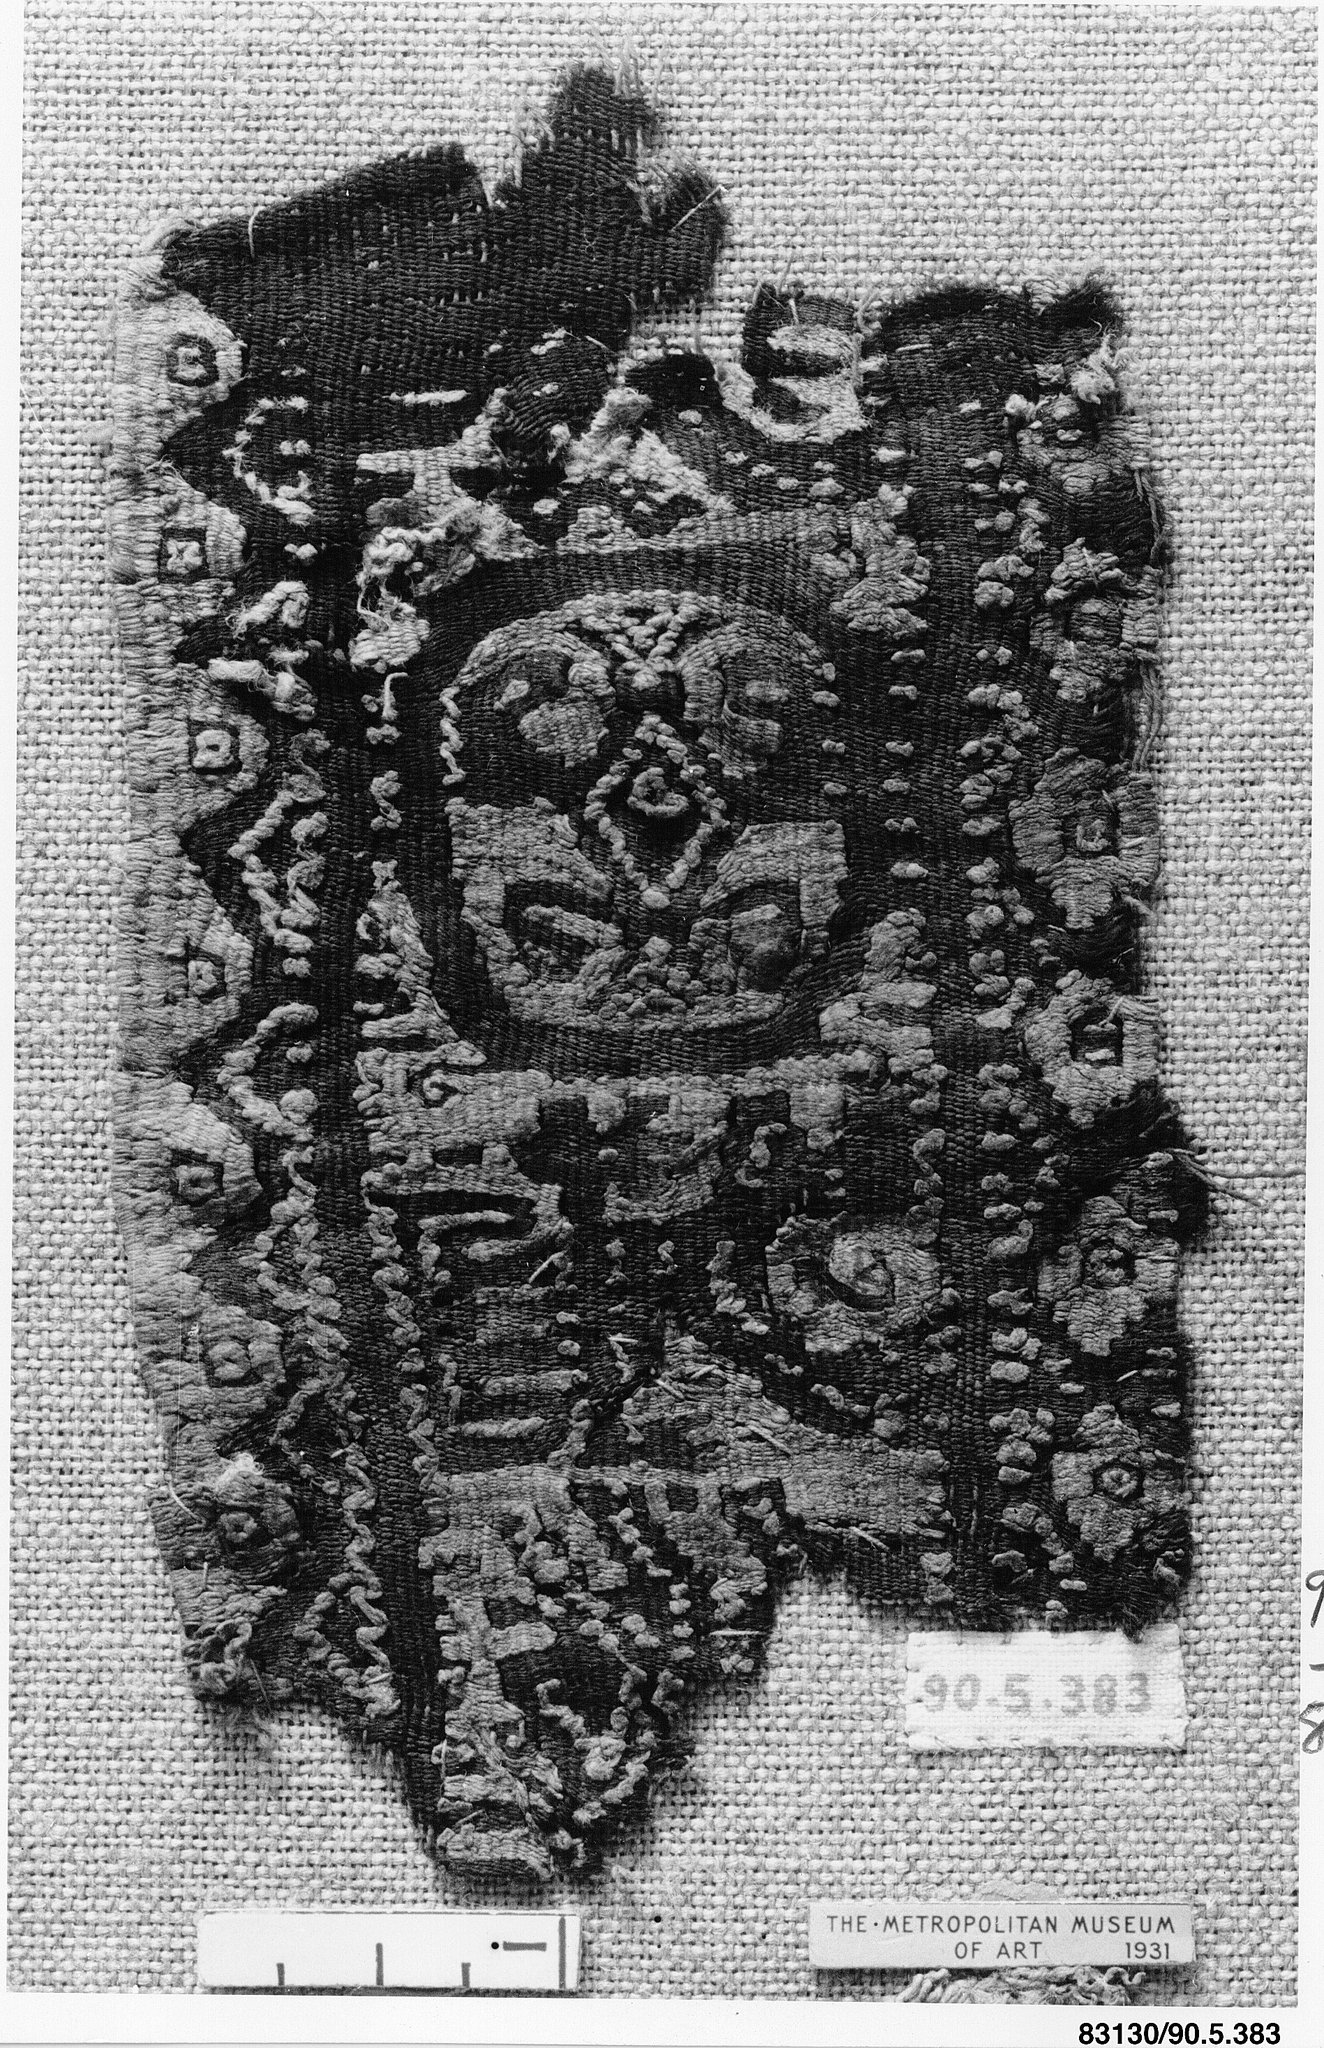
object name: textile fragment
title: Fragment of a Band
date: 301-500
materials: linen, wool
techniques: weave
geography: egypt